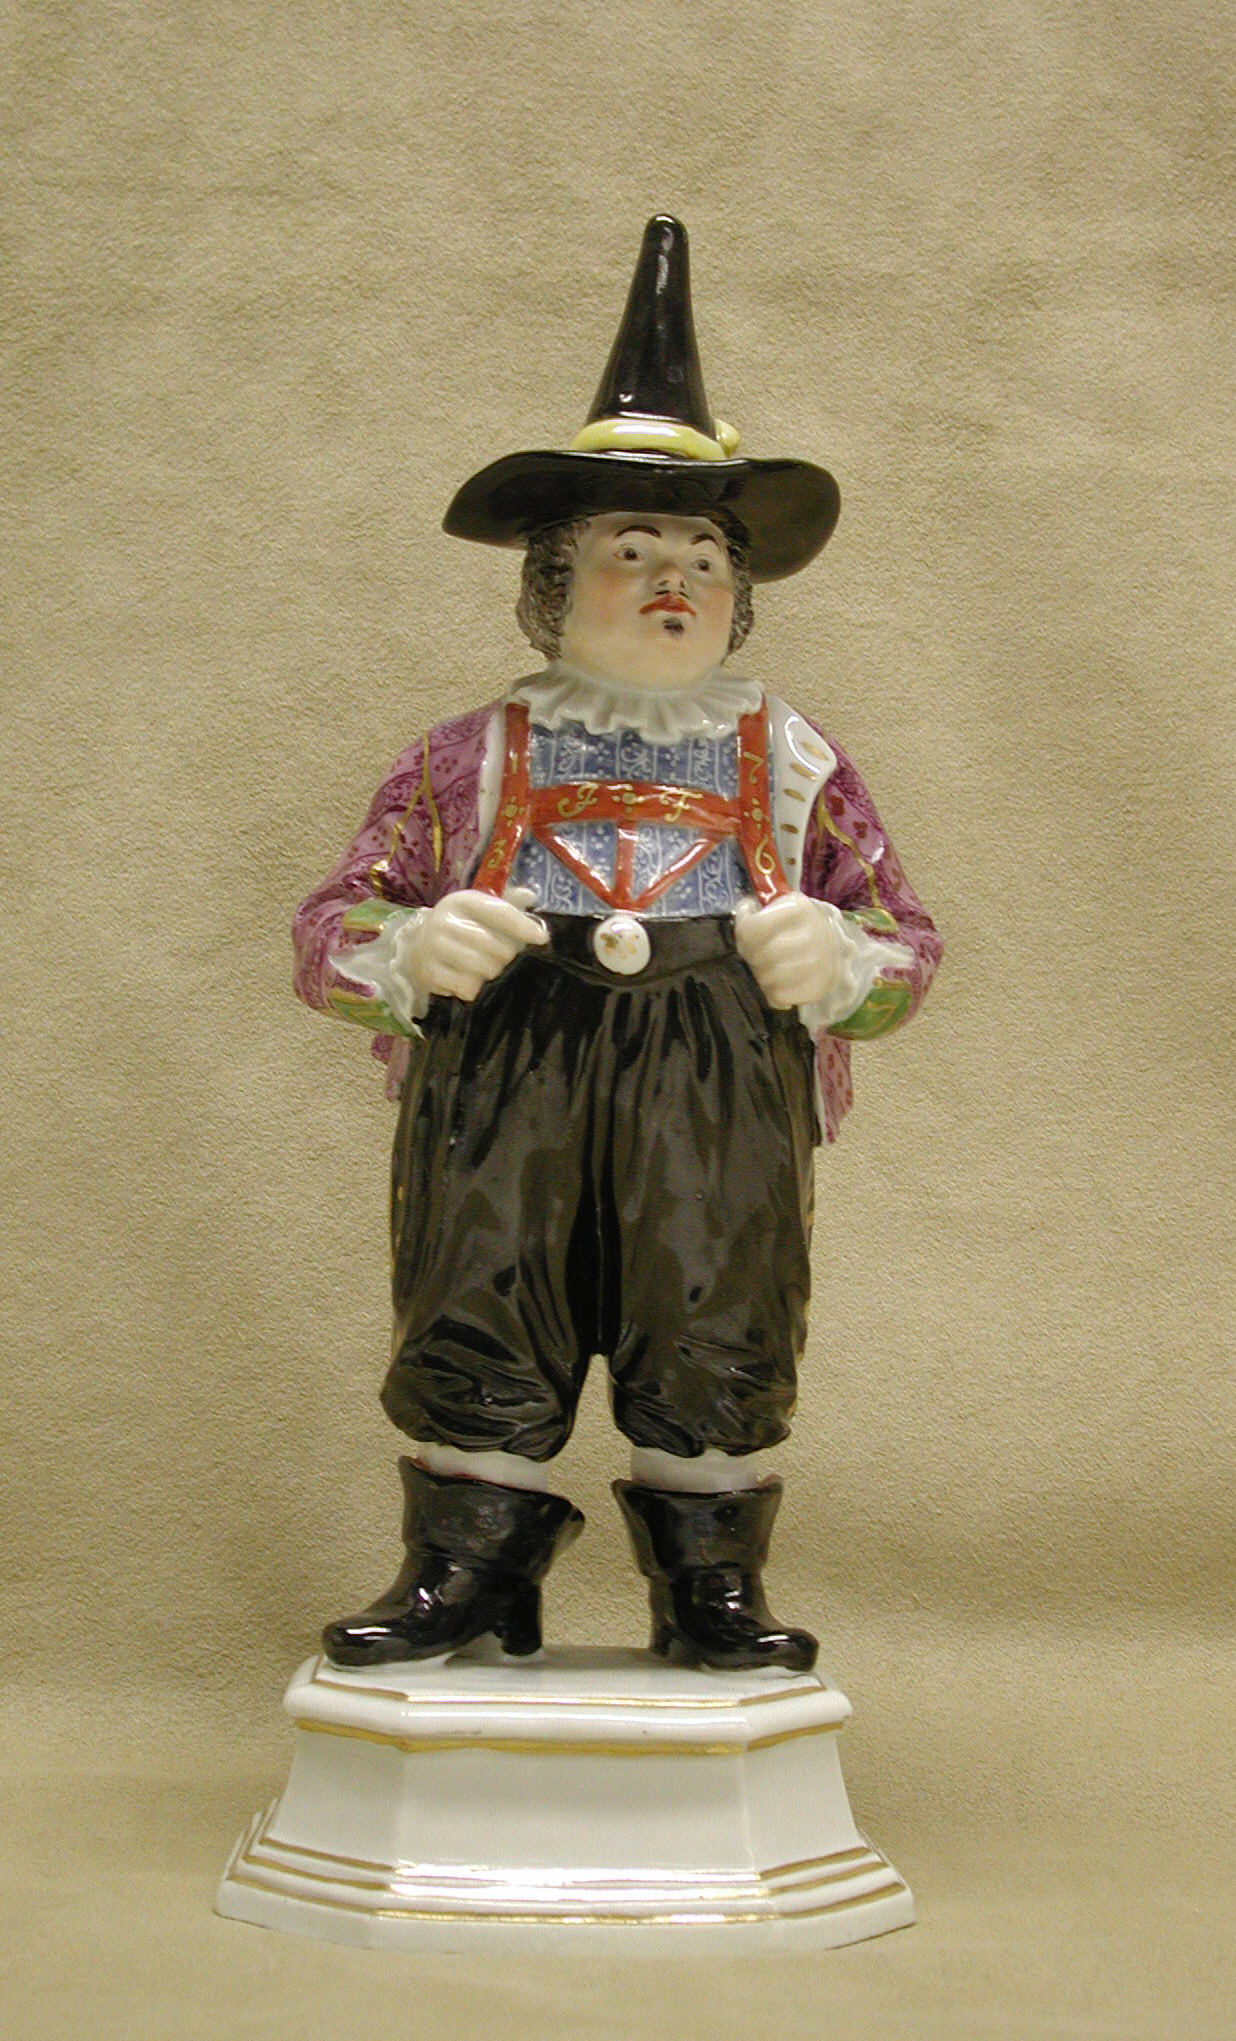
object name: figure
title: Joseph Fröhlich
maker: meissen manufactory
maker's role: manufactory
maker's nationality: german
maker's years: 1710-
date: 1736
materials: hard paste porcelain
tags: men